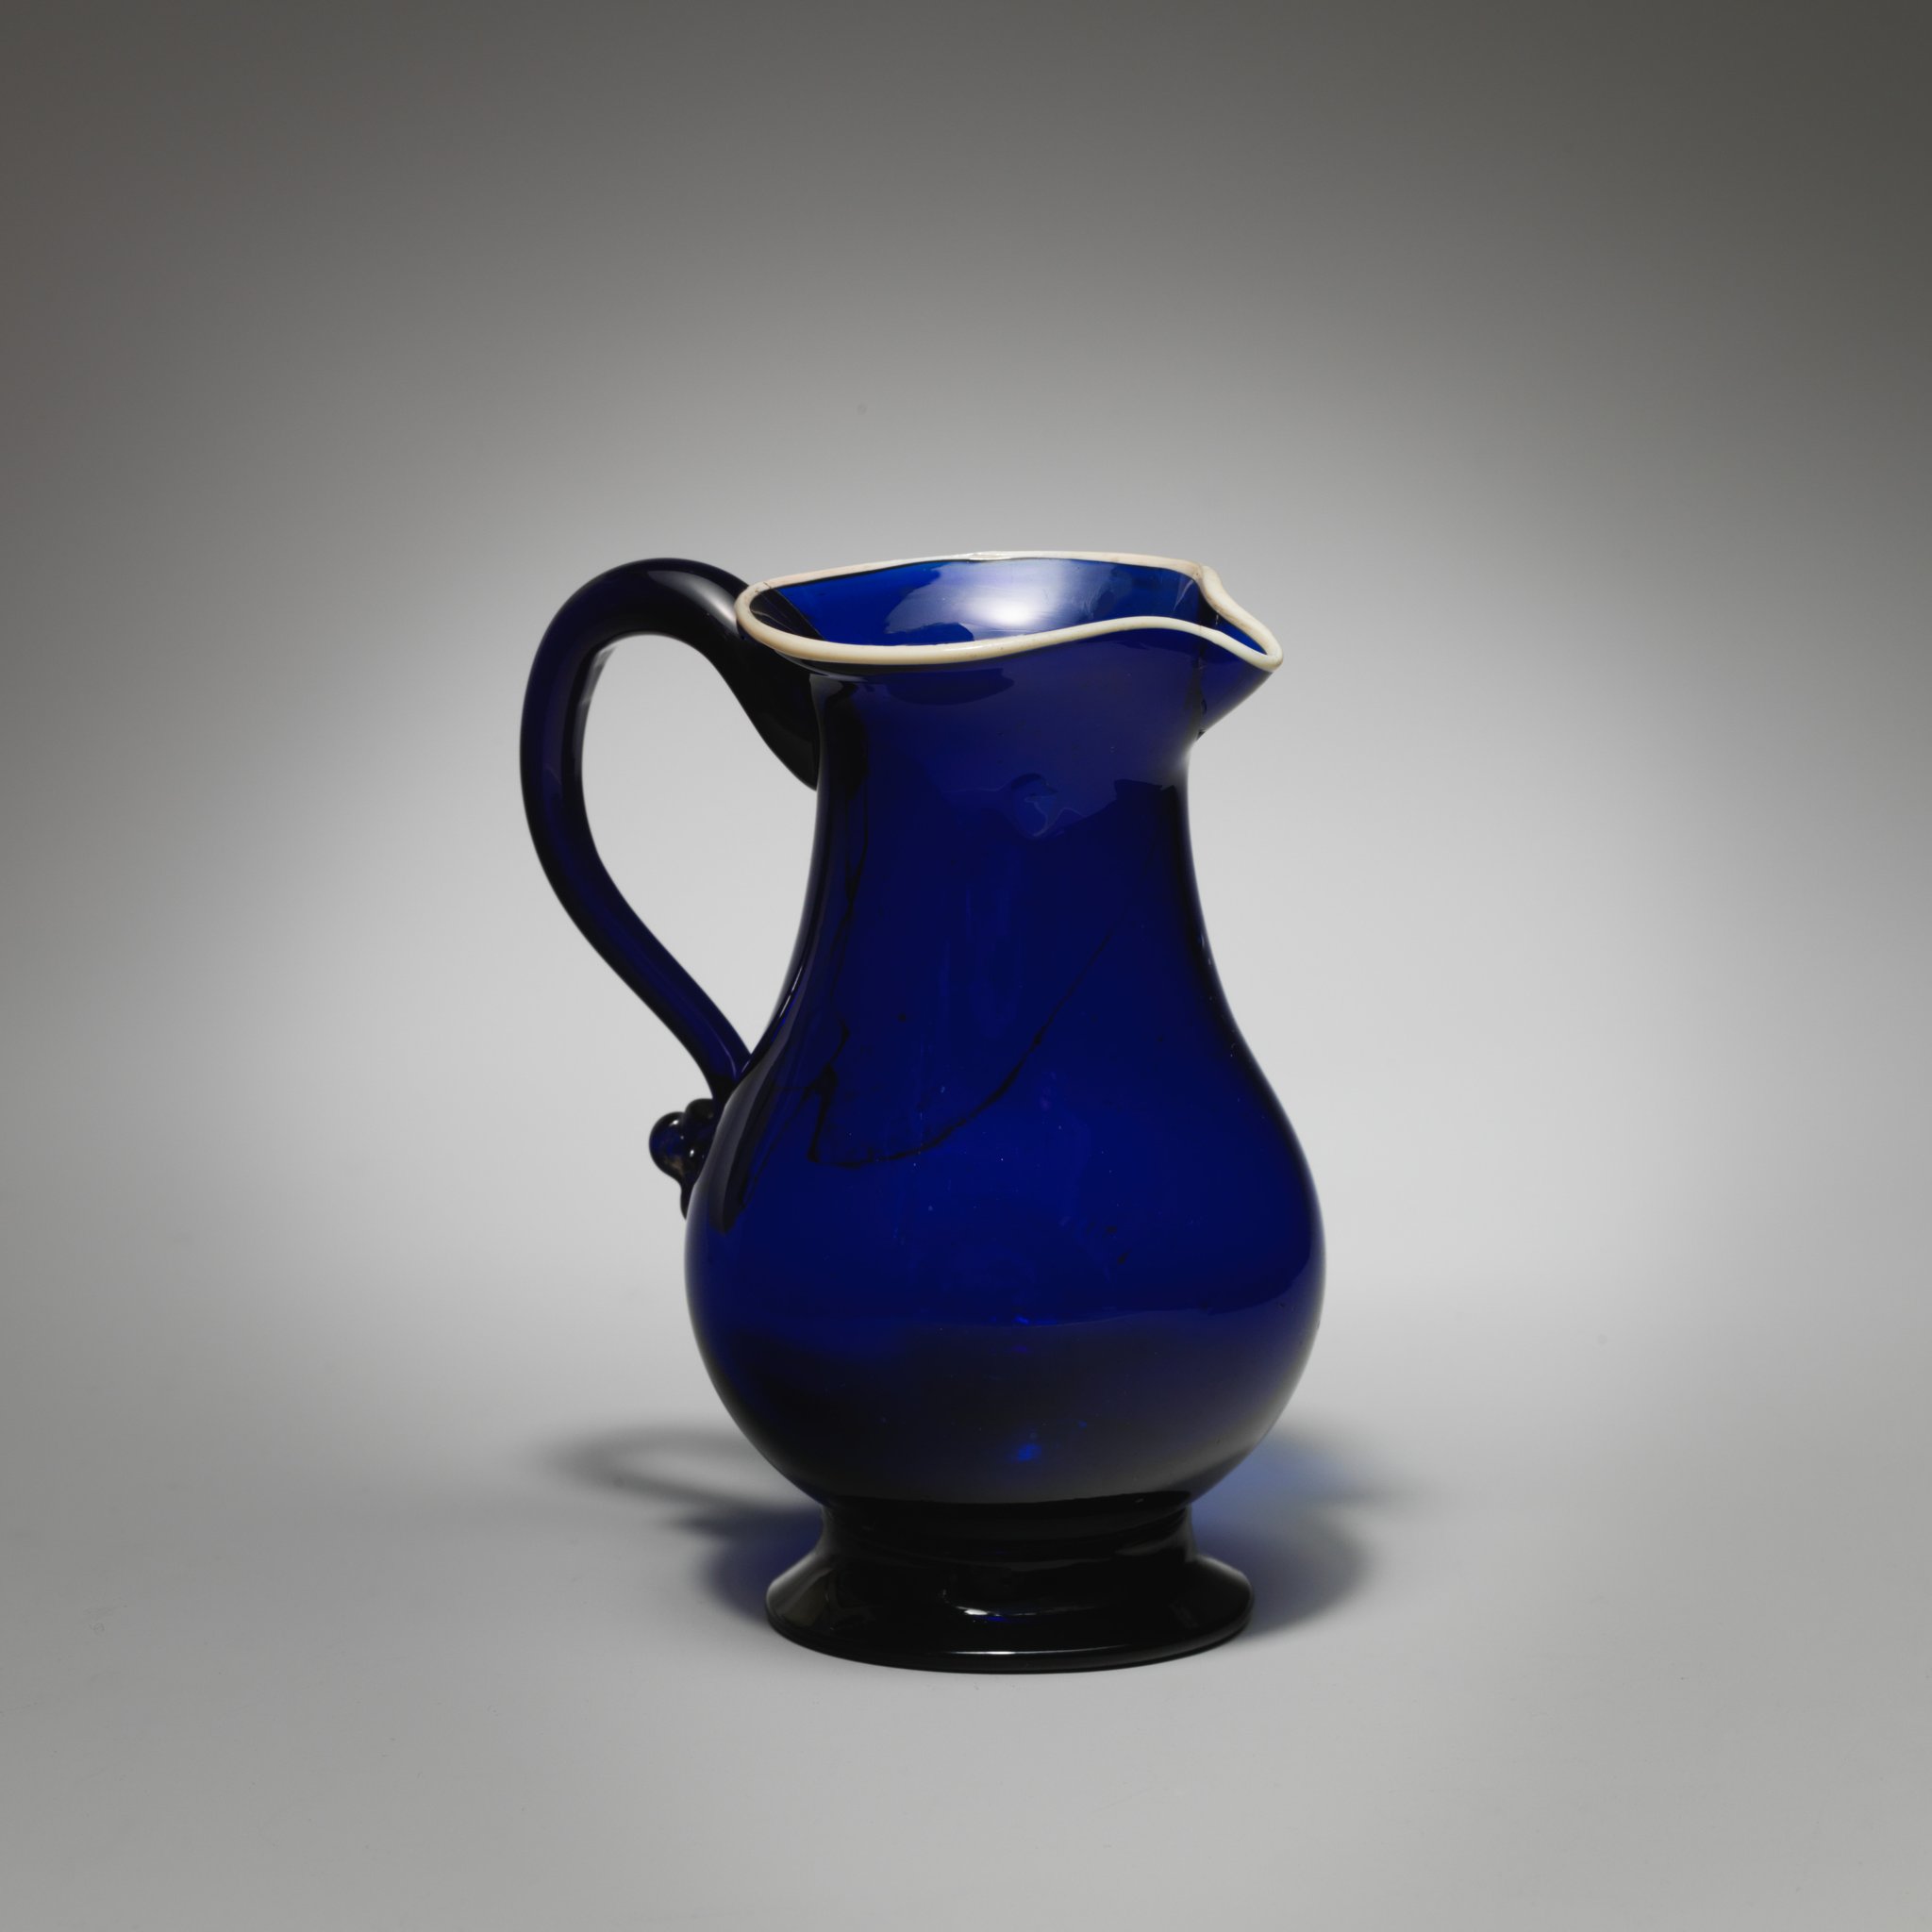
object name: cream pitcher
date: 1701-1800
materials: glass